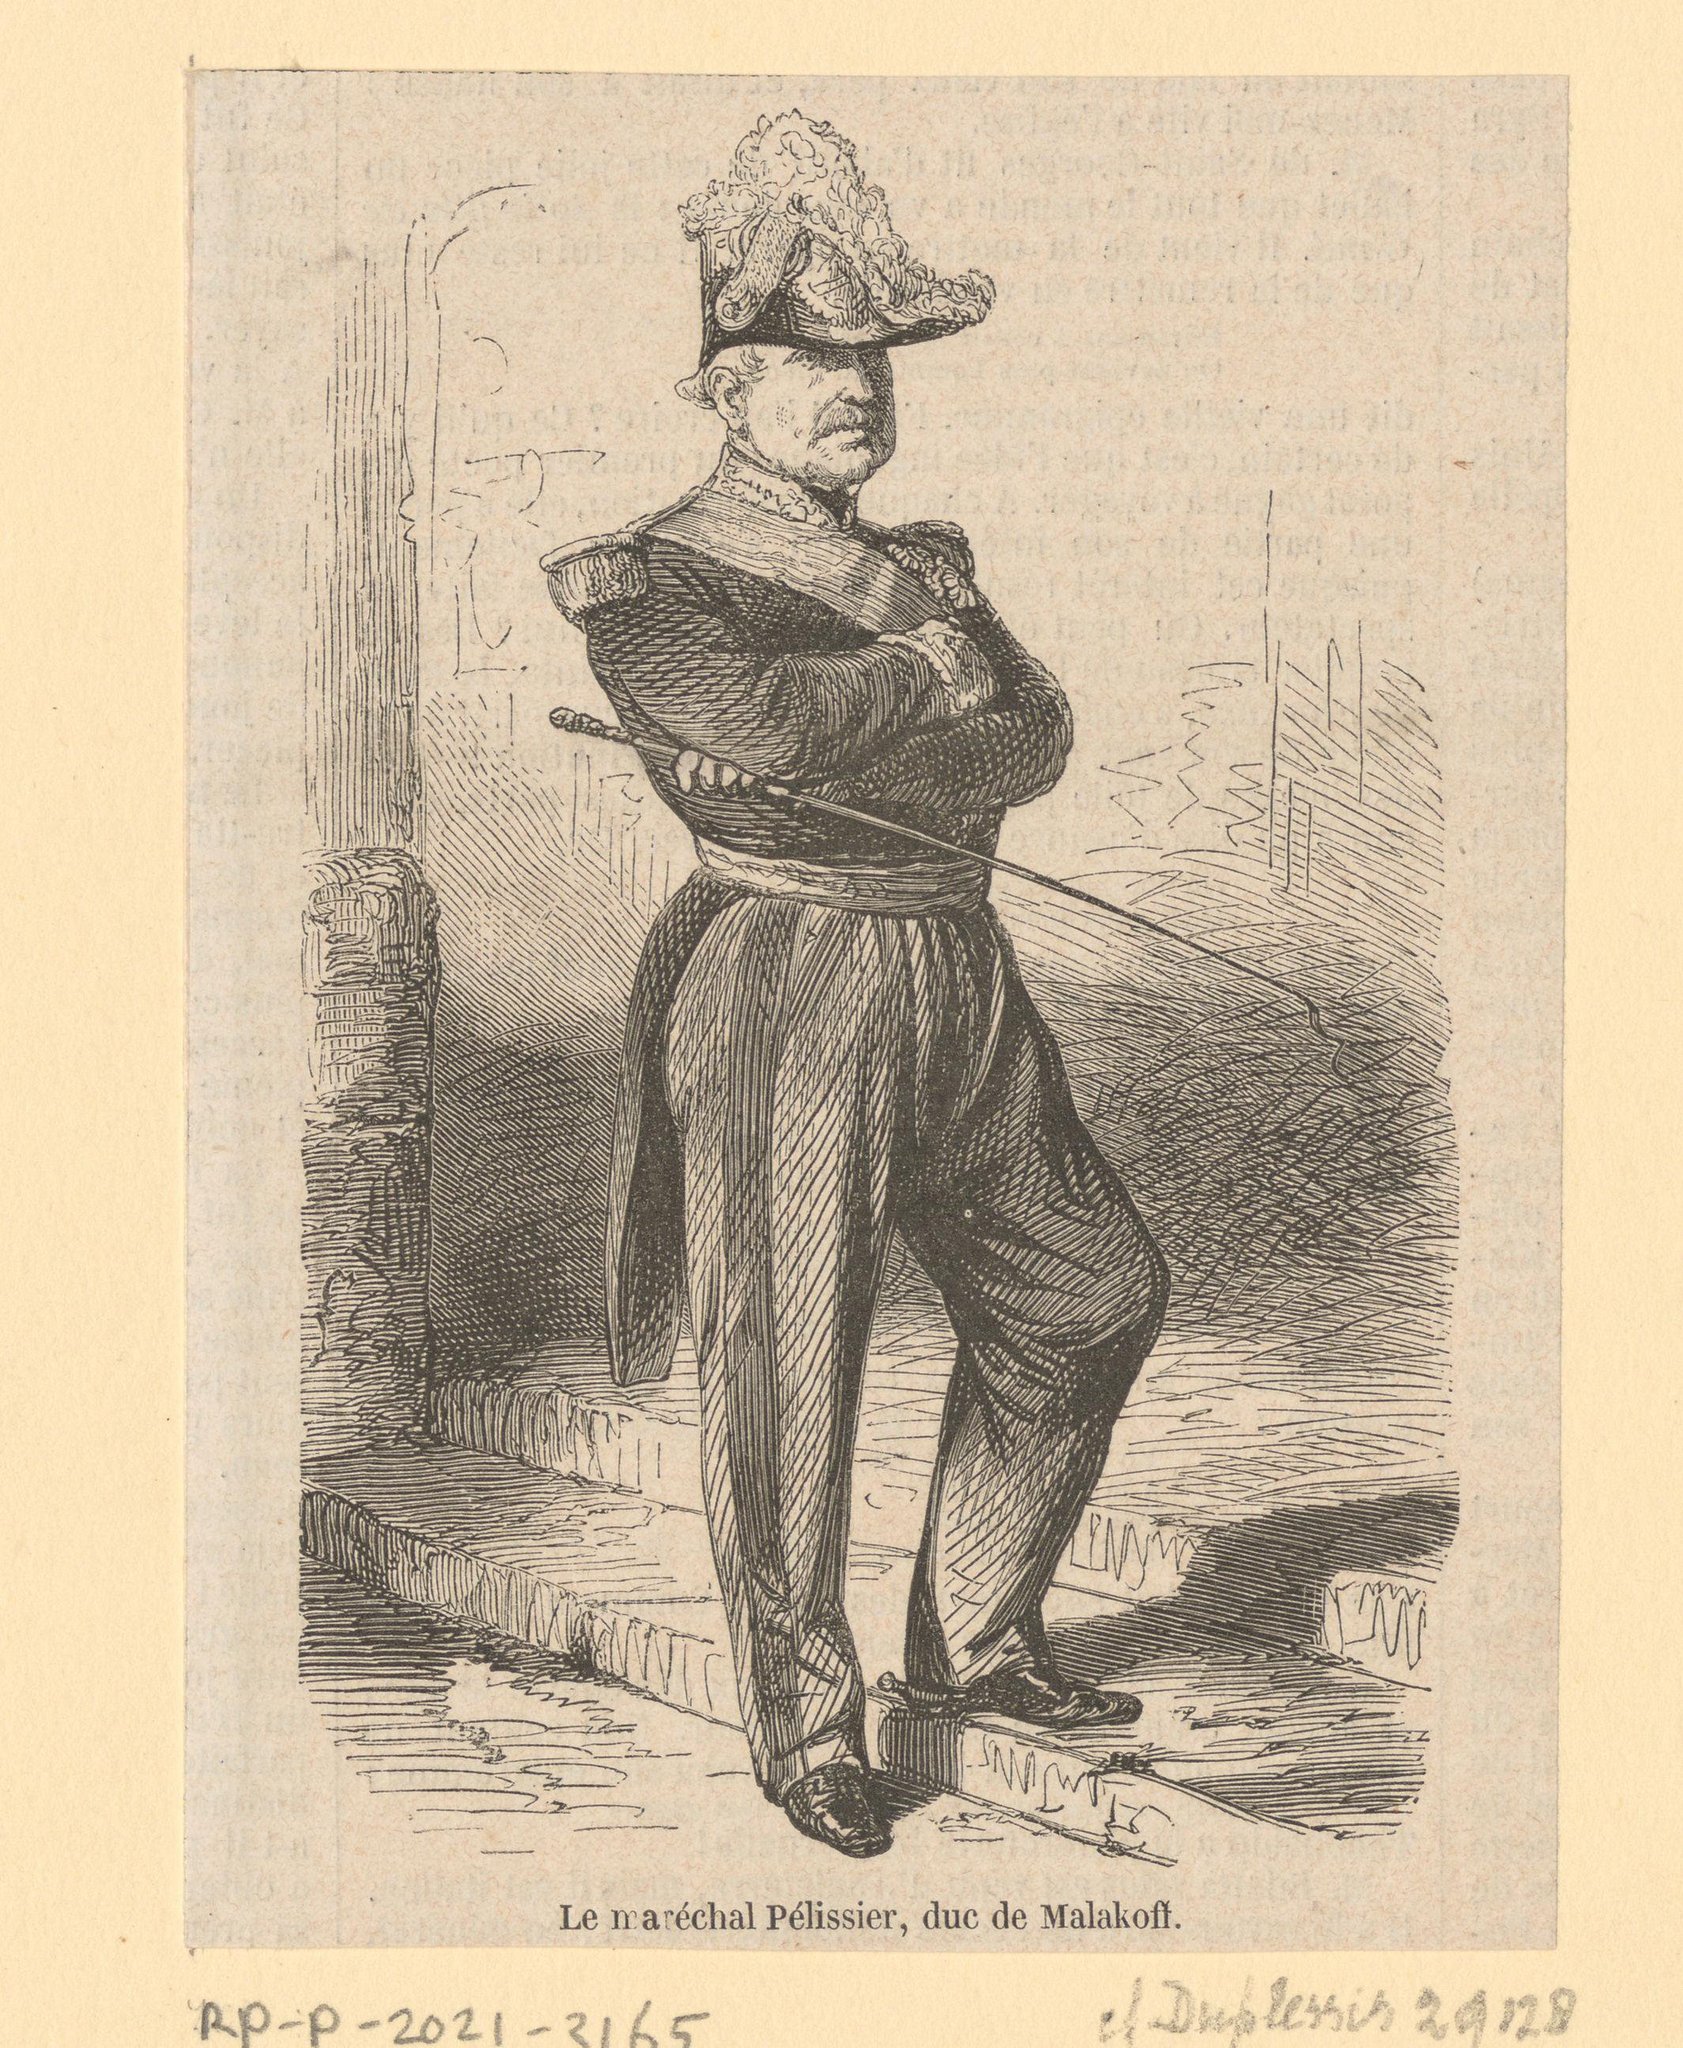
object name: print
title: Portret van Aimable Pélissier, hertog van Malakoff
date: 1856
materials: paper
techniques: letterpress printing, engraving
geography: paris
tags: commander-in-chief, general, marshal, historical persons, (military) uniforms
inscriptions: inscription: ‘Janet Lange sc’, stamp: ‘L'Illustration/ 15 Nov. 1856’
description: Prent uit: L'Illustration 28 (1856), nr. 716, 15 november 1856.